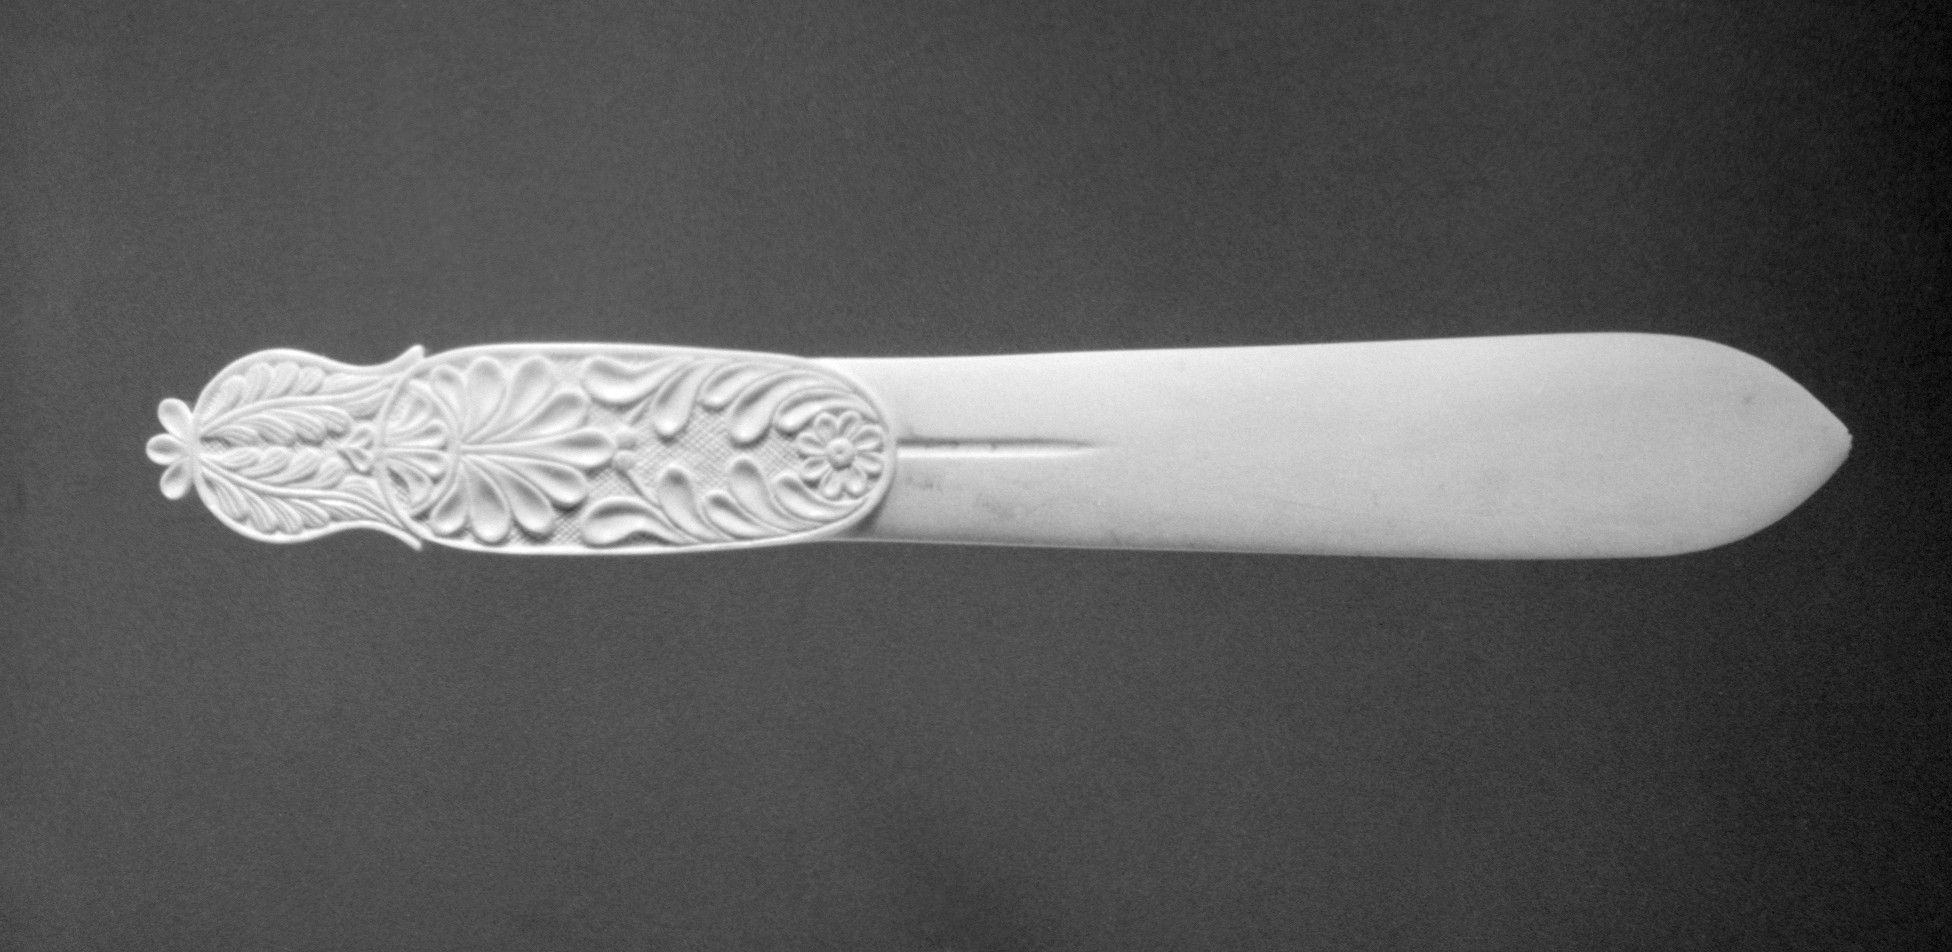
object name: letter opener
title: Letter opener (part of a set)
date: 1848-1849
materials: ivory